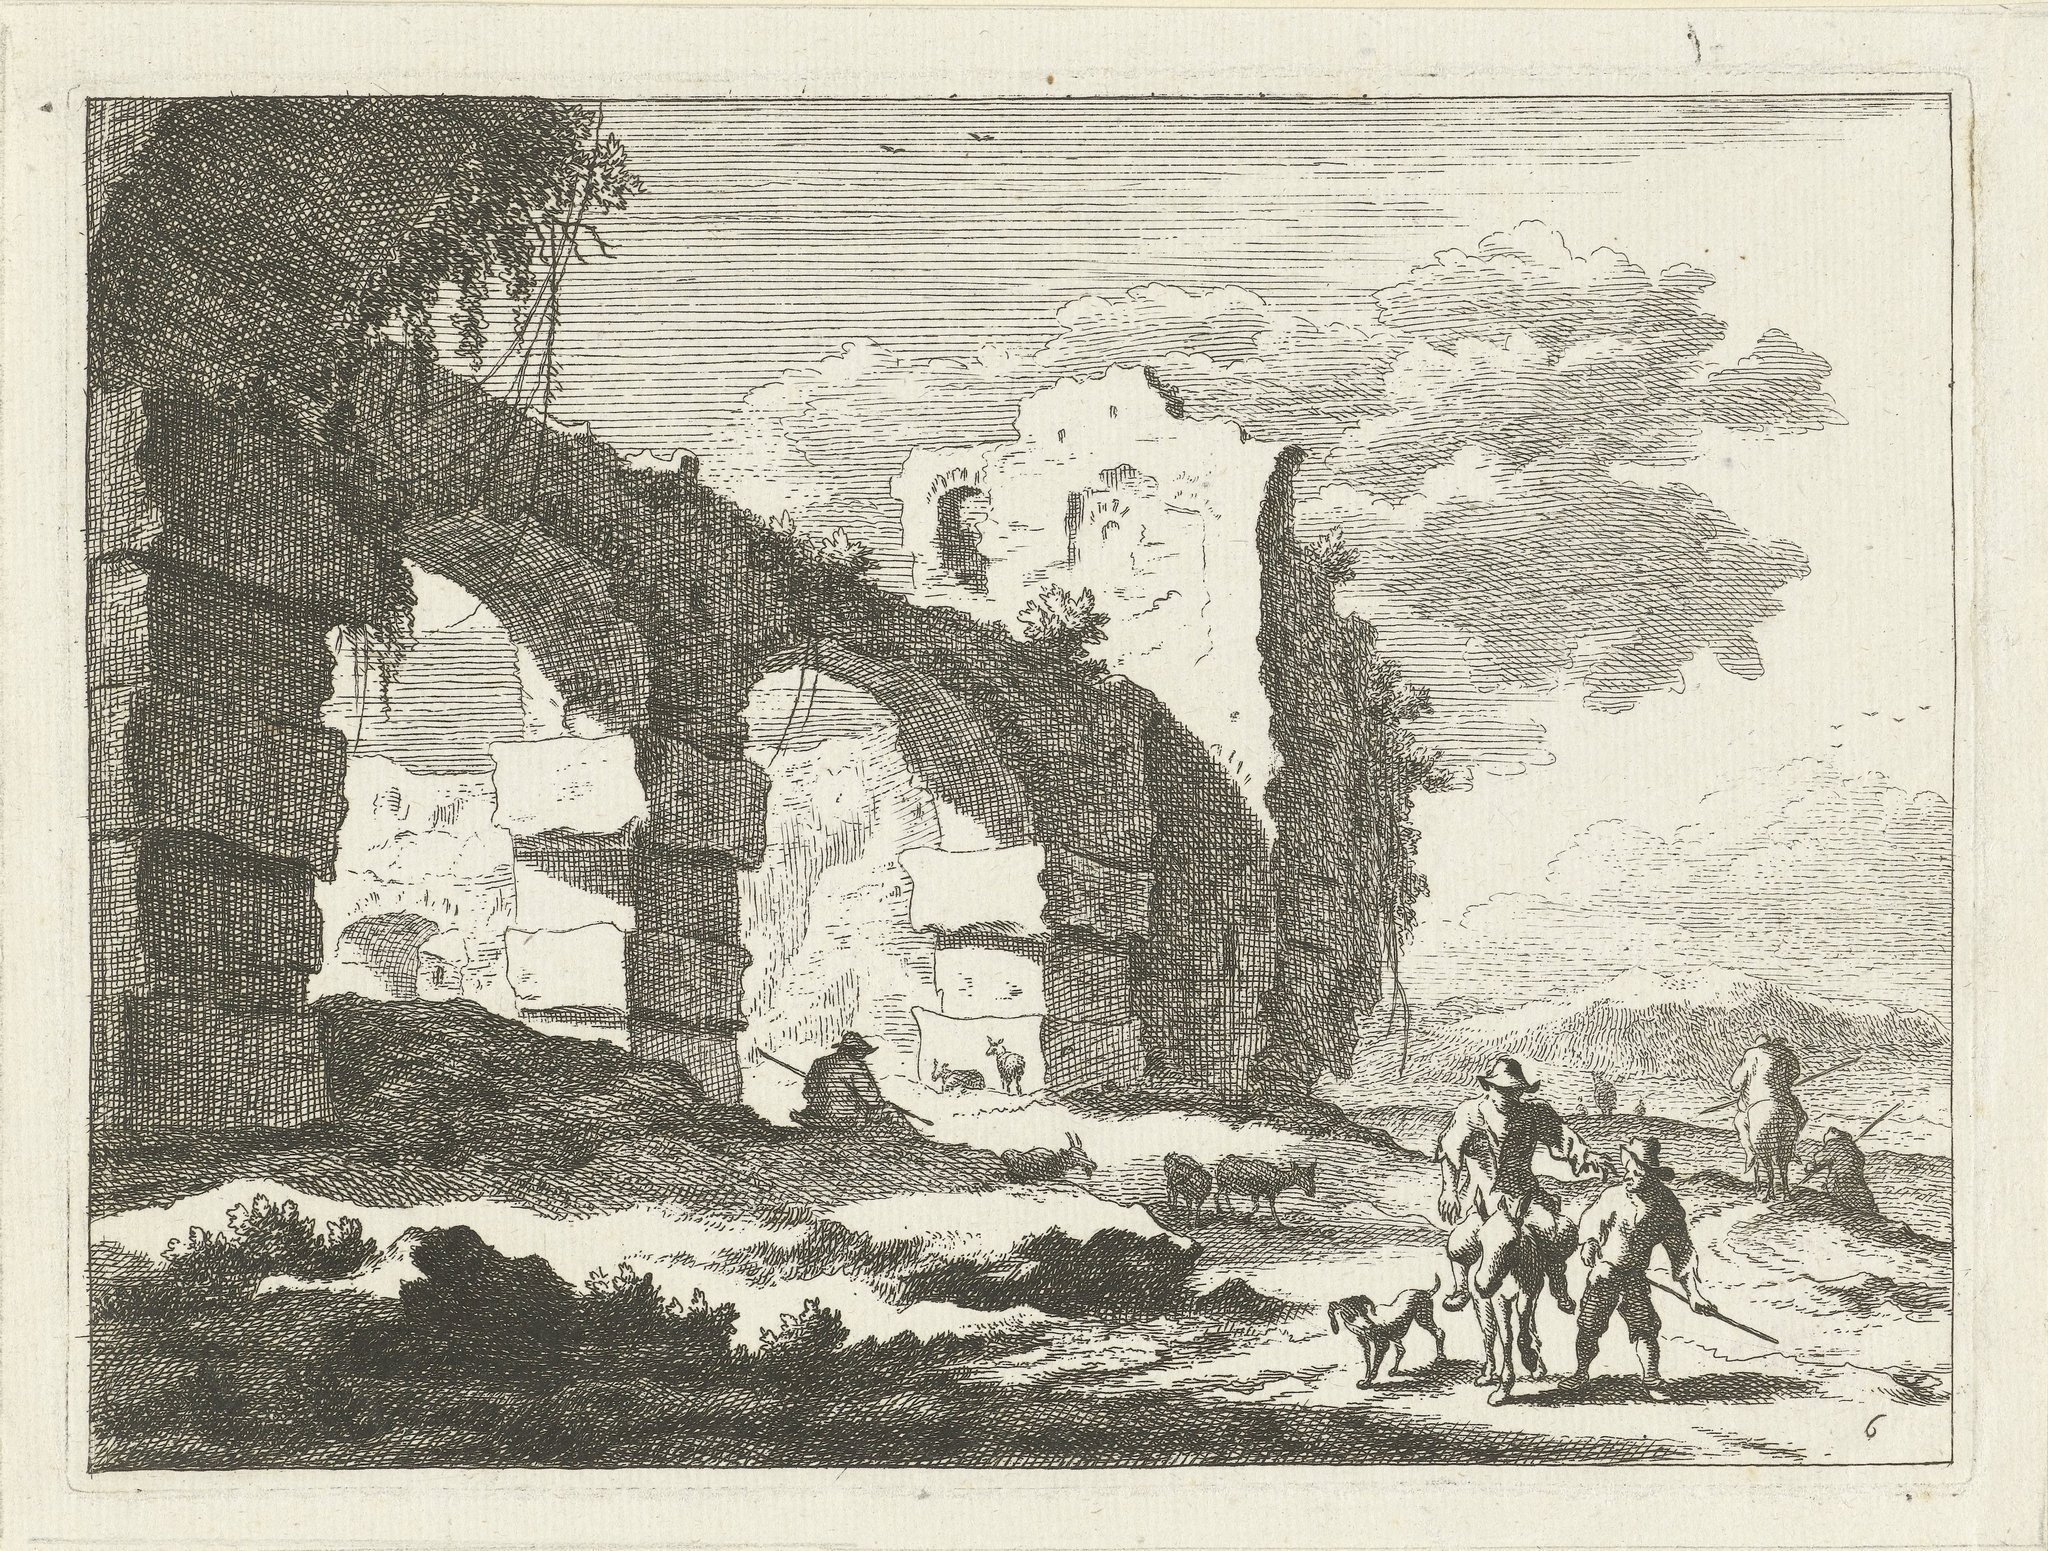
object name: print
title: Landschap met ruïne en herder op ezel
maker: johannes gronsveld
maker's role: draughtsman, painter, print maker, publisher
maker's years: 1658-1728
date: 1679-1728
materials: paper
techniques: engraving, etching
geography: amsterdam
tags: landscape with ruins, landscapes (+ landscape with figures, staffage)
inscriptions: collector's mark: Lugt 240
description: Landschap met een ruïne en een herder zittend op een heuvel. Rechtsvoor een herder op een ezel, geflankeerd door een hond en een herder. Zesde prent uit een serie van zes met landschappen met herders en vee.